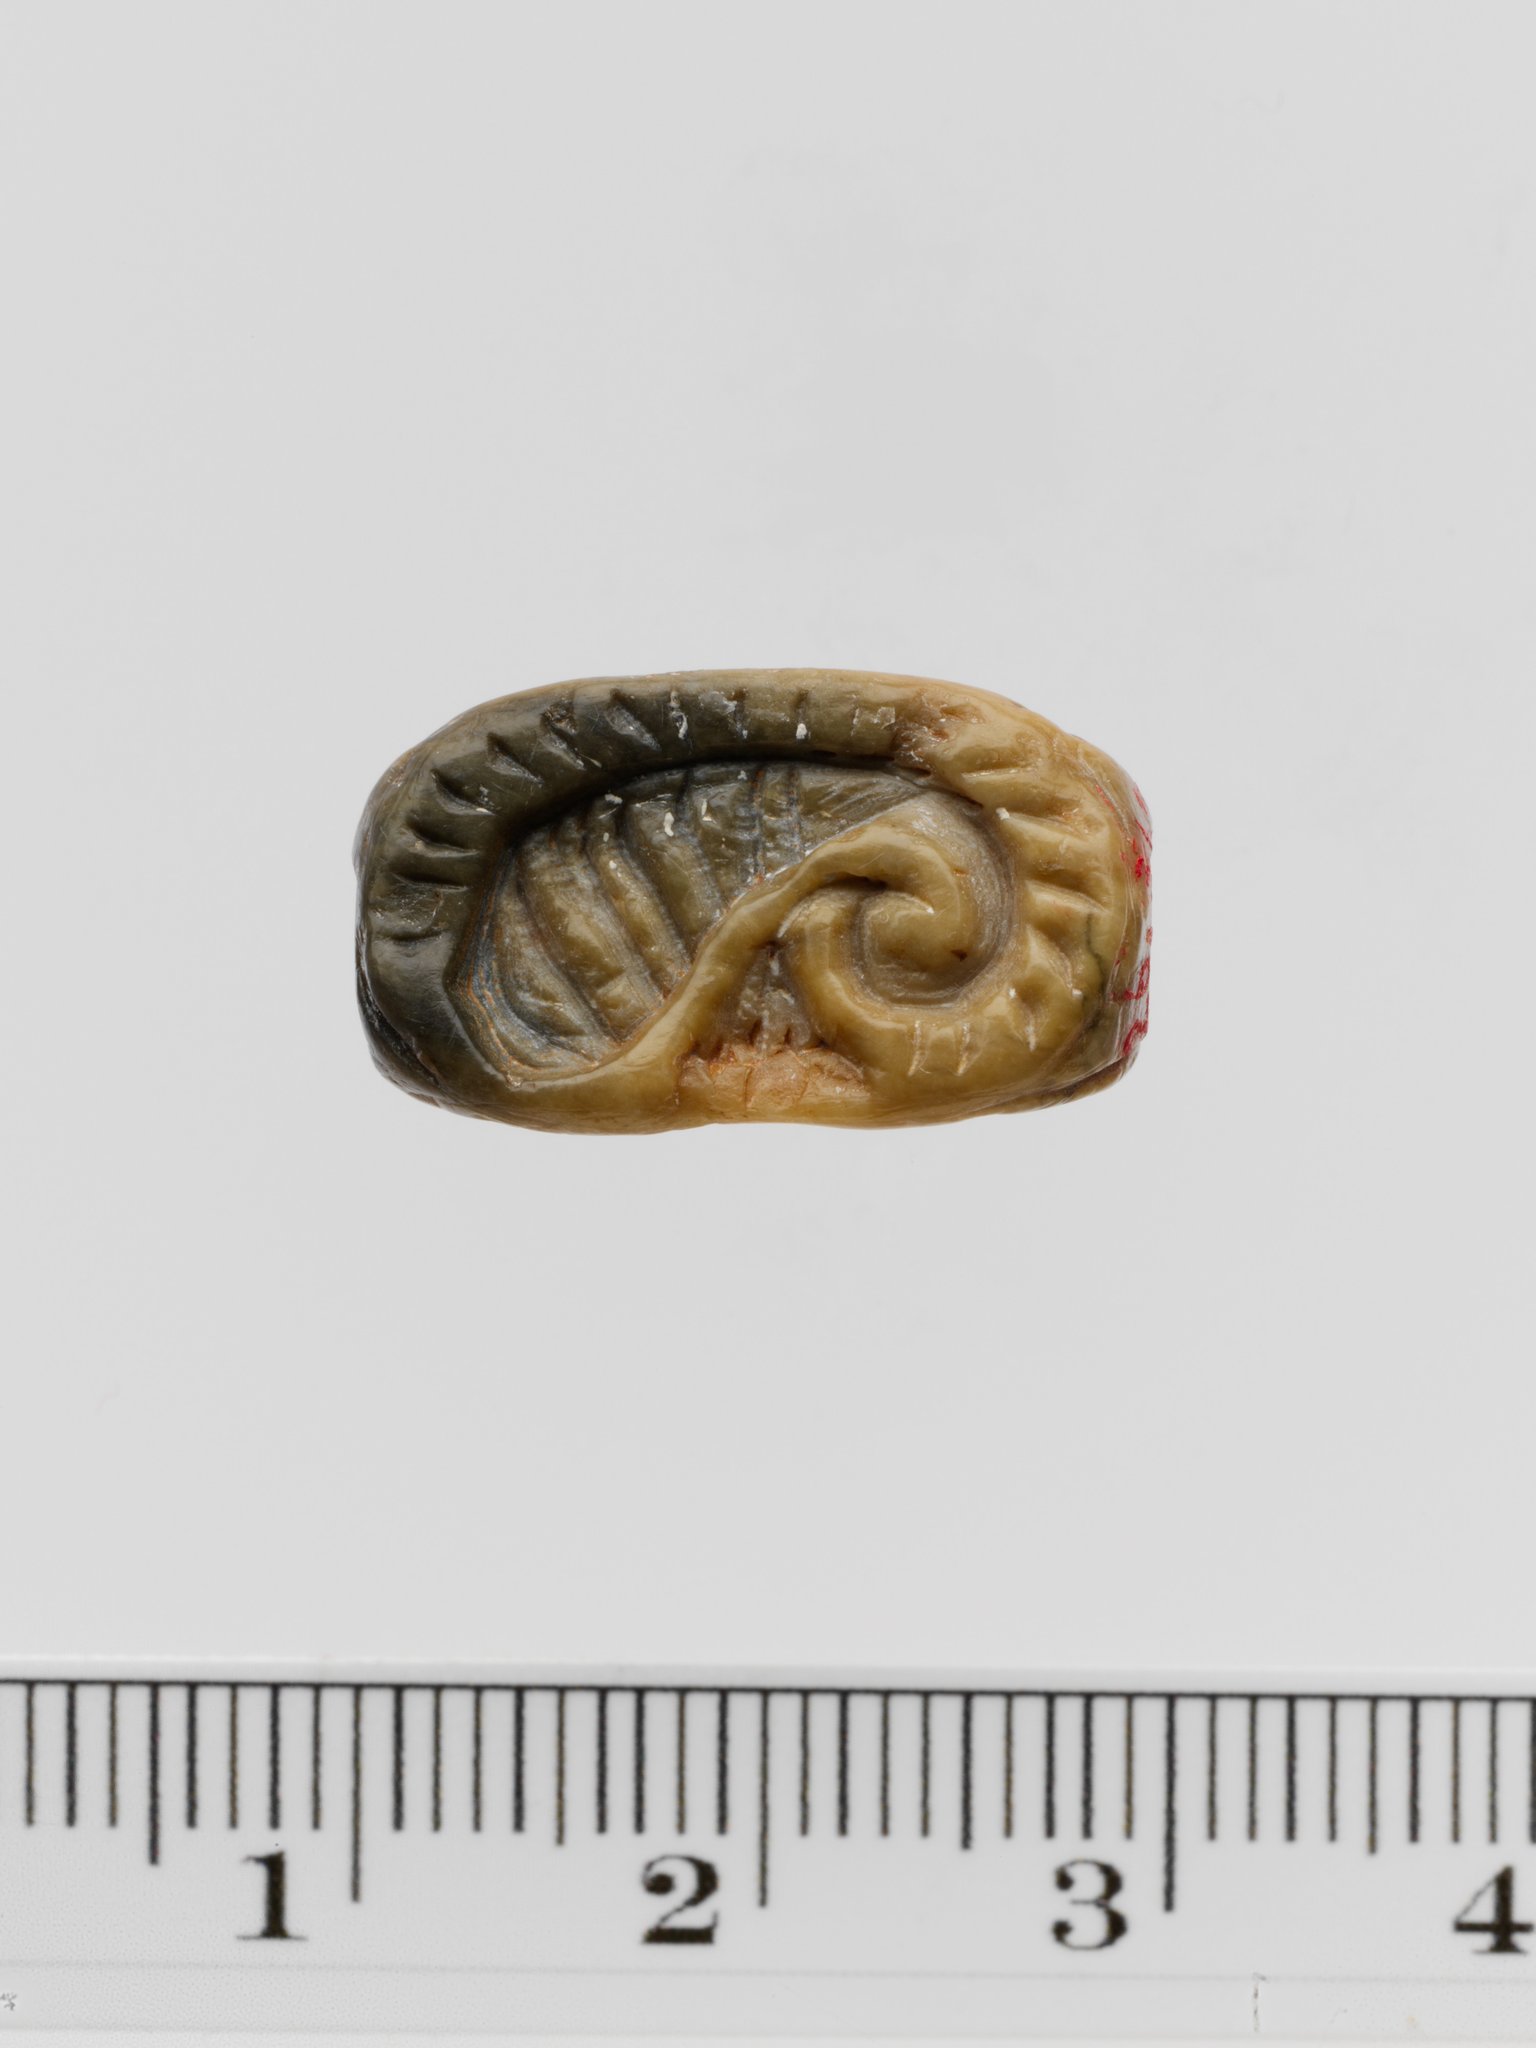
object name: seal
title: Steatite triangular prism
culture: minoan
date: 1900-1750 BCE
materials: stone